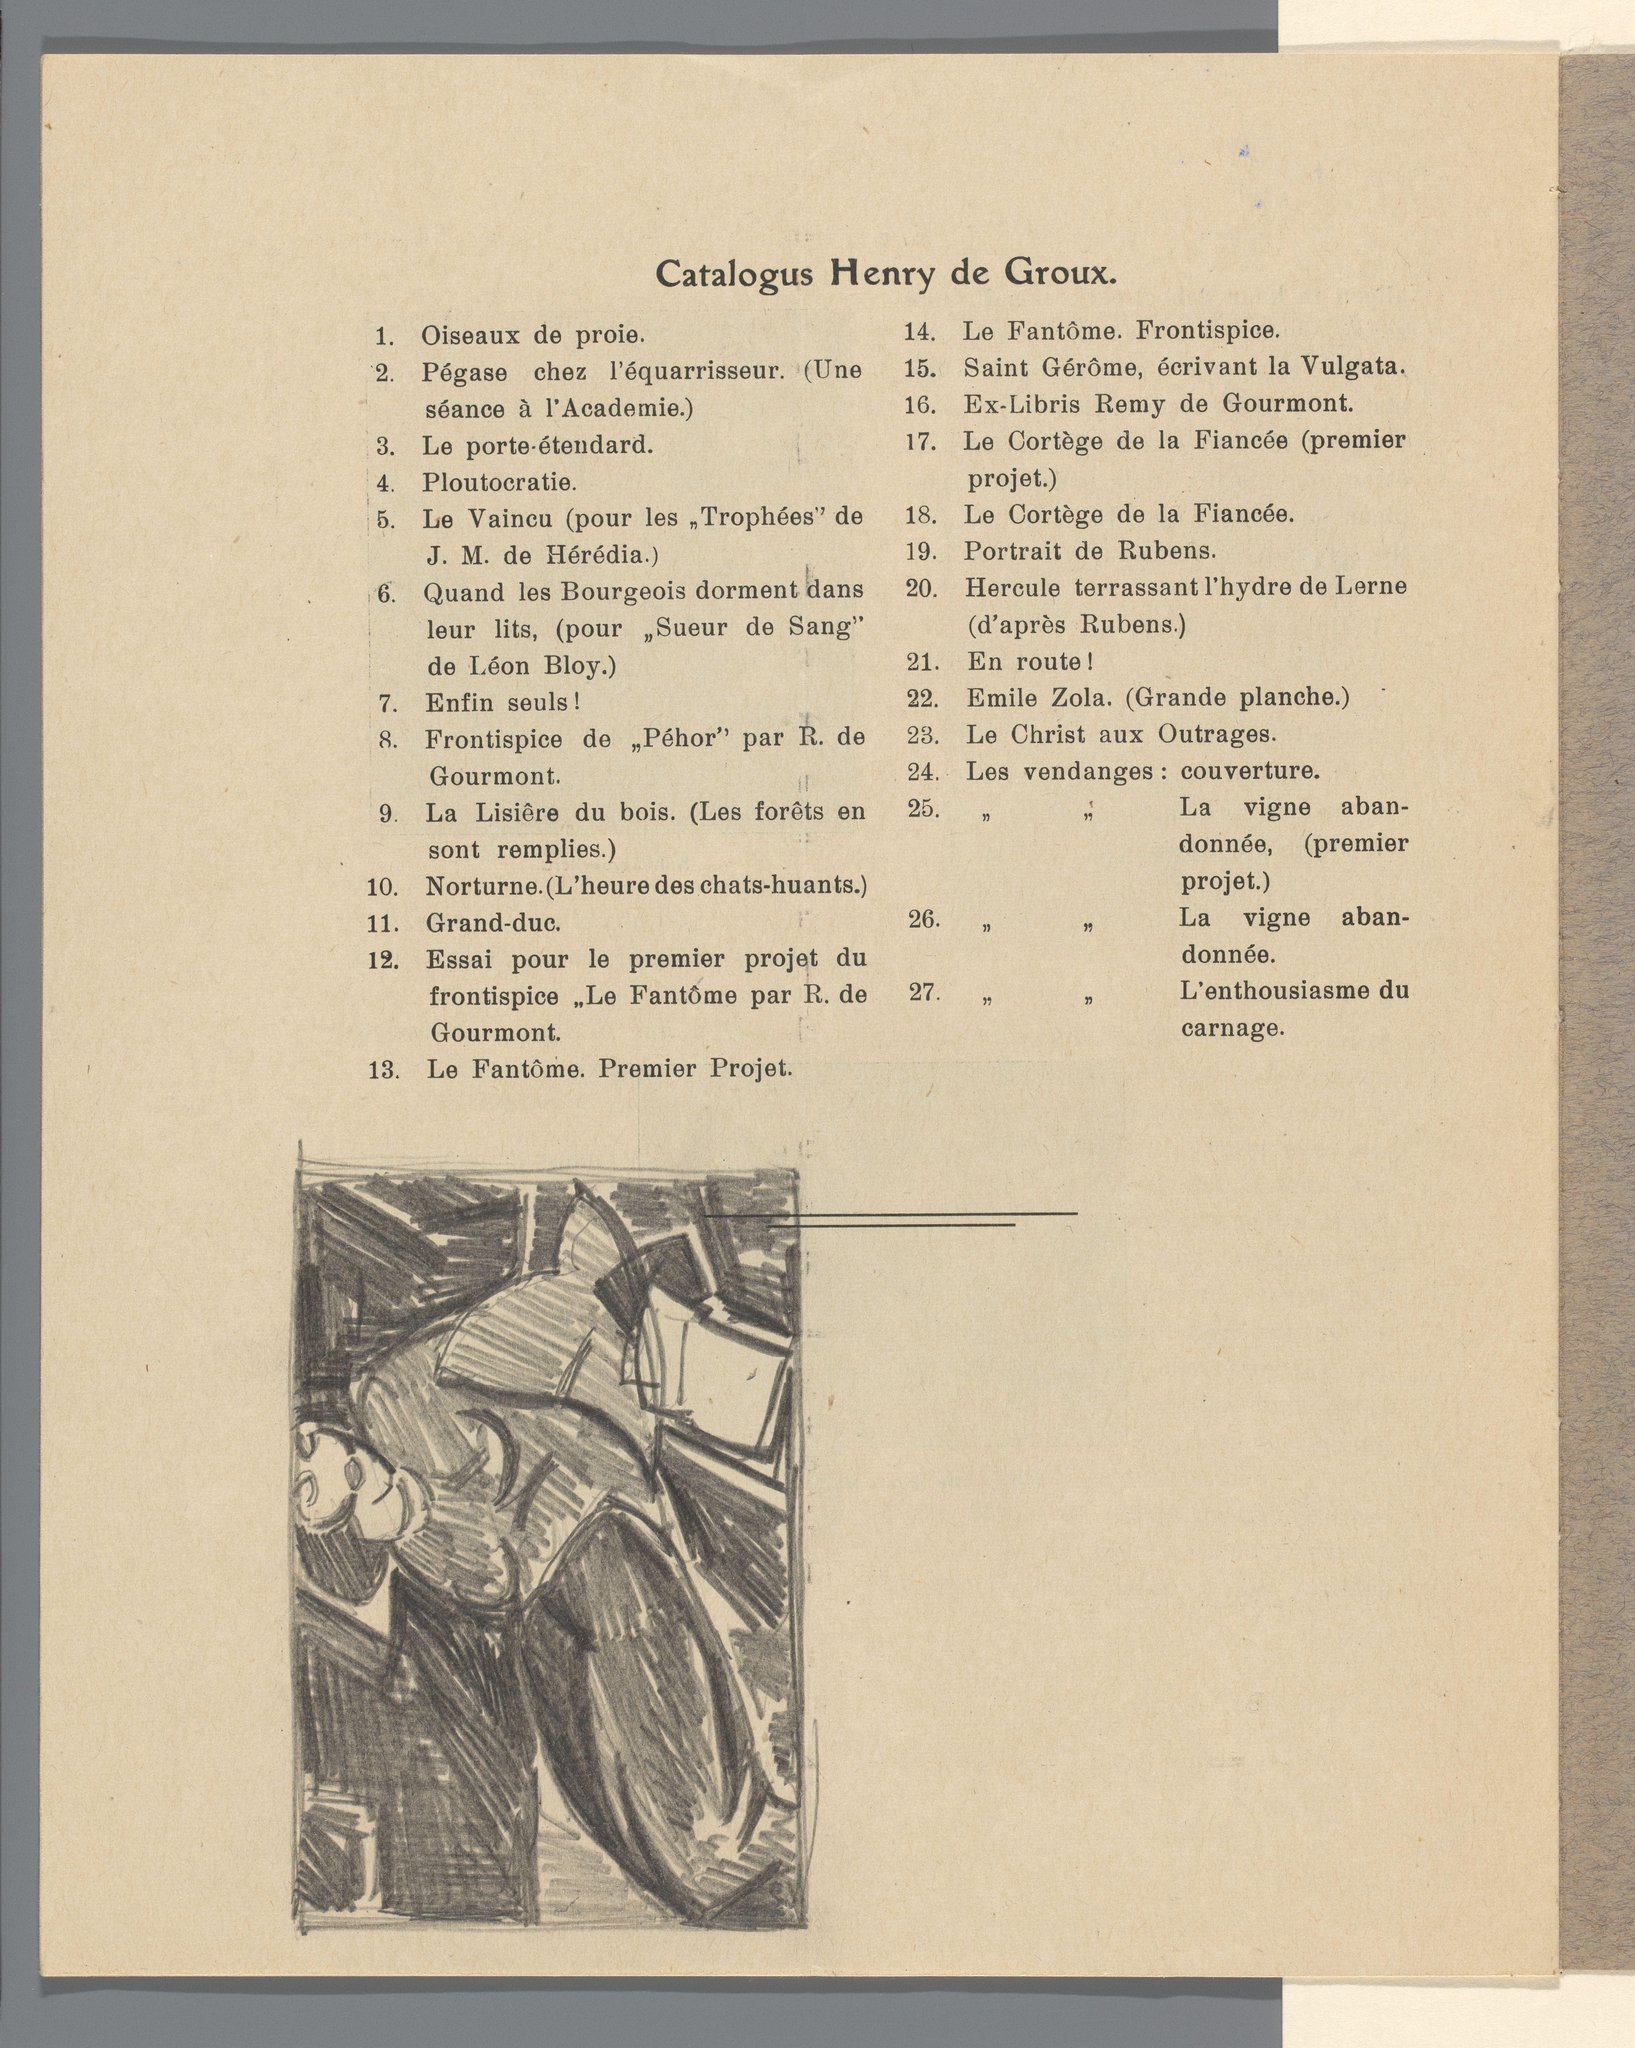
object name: drawing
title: Zittende vrouw met een opengeslagen boek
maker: reijer stolk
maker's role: draughtsman, print maker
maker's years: 1896-1945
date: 1920-1945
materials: paper, pencil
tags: book, sitting on an elevation - aa - female human figure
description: De tekening is gemaakt op de laatste bladzijde van J.H. de Bois' Tweemaandelijksch Bulletin 3 (1920), nr. 5, 1 oktober 1920.